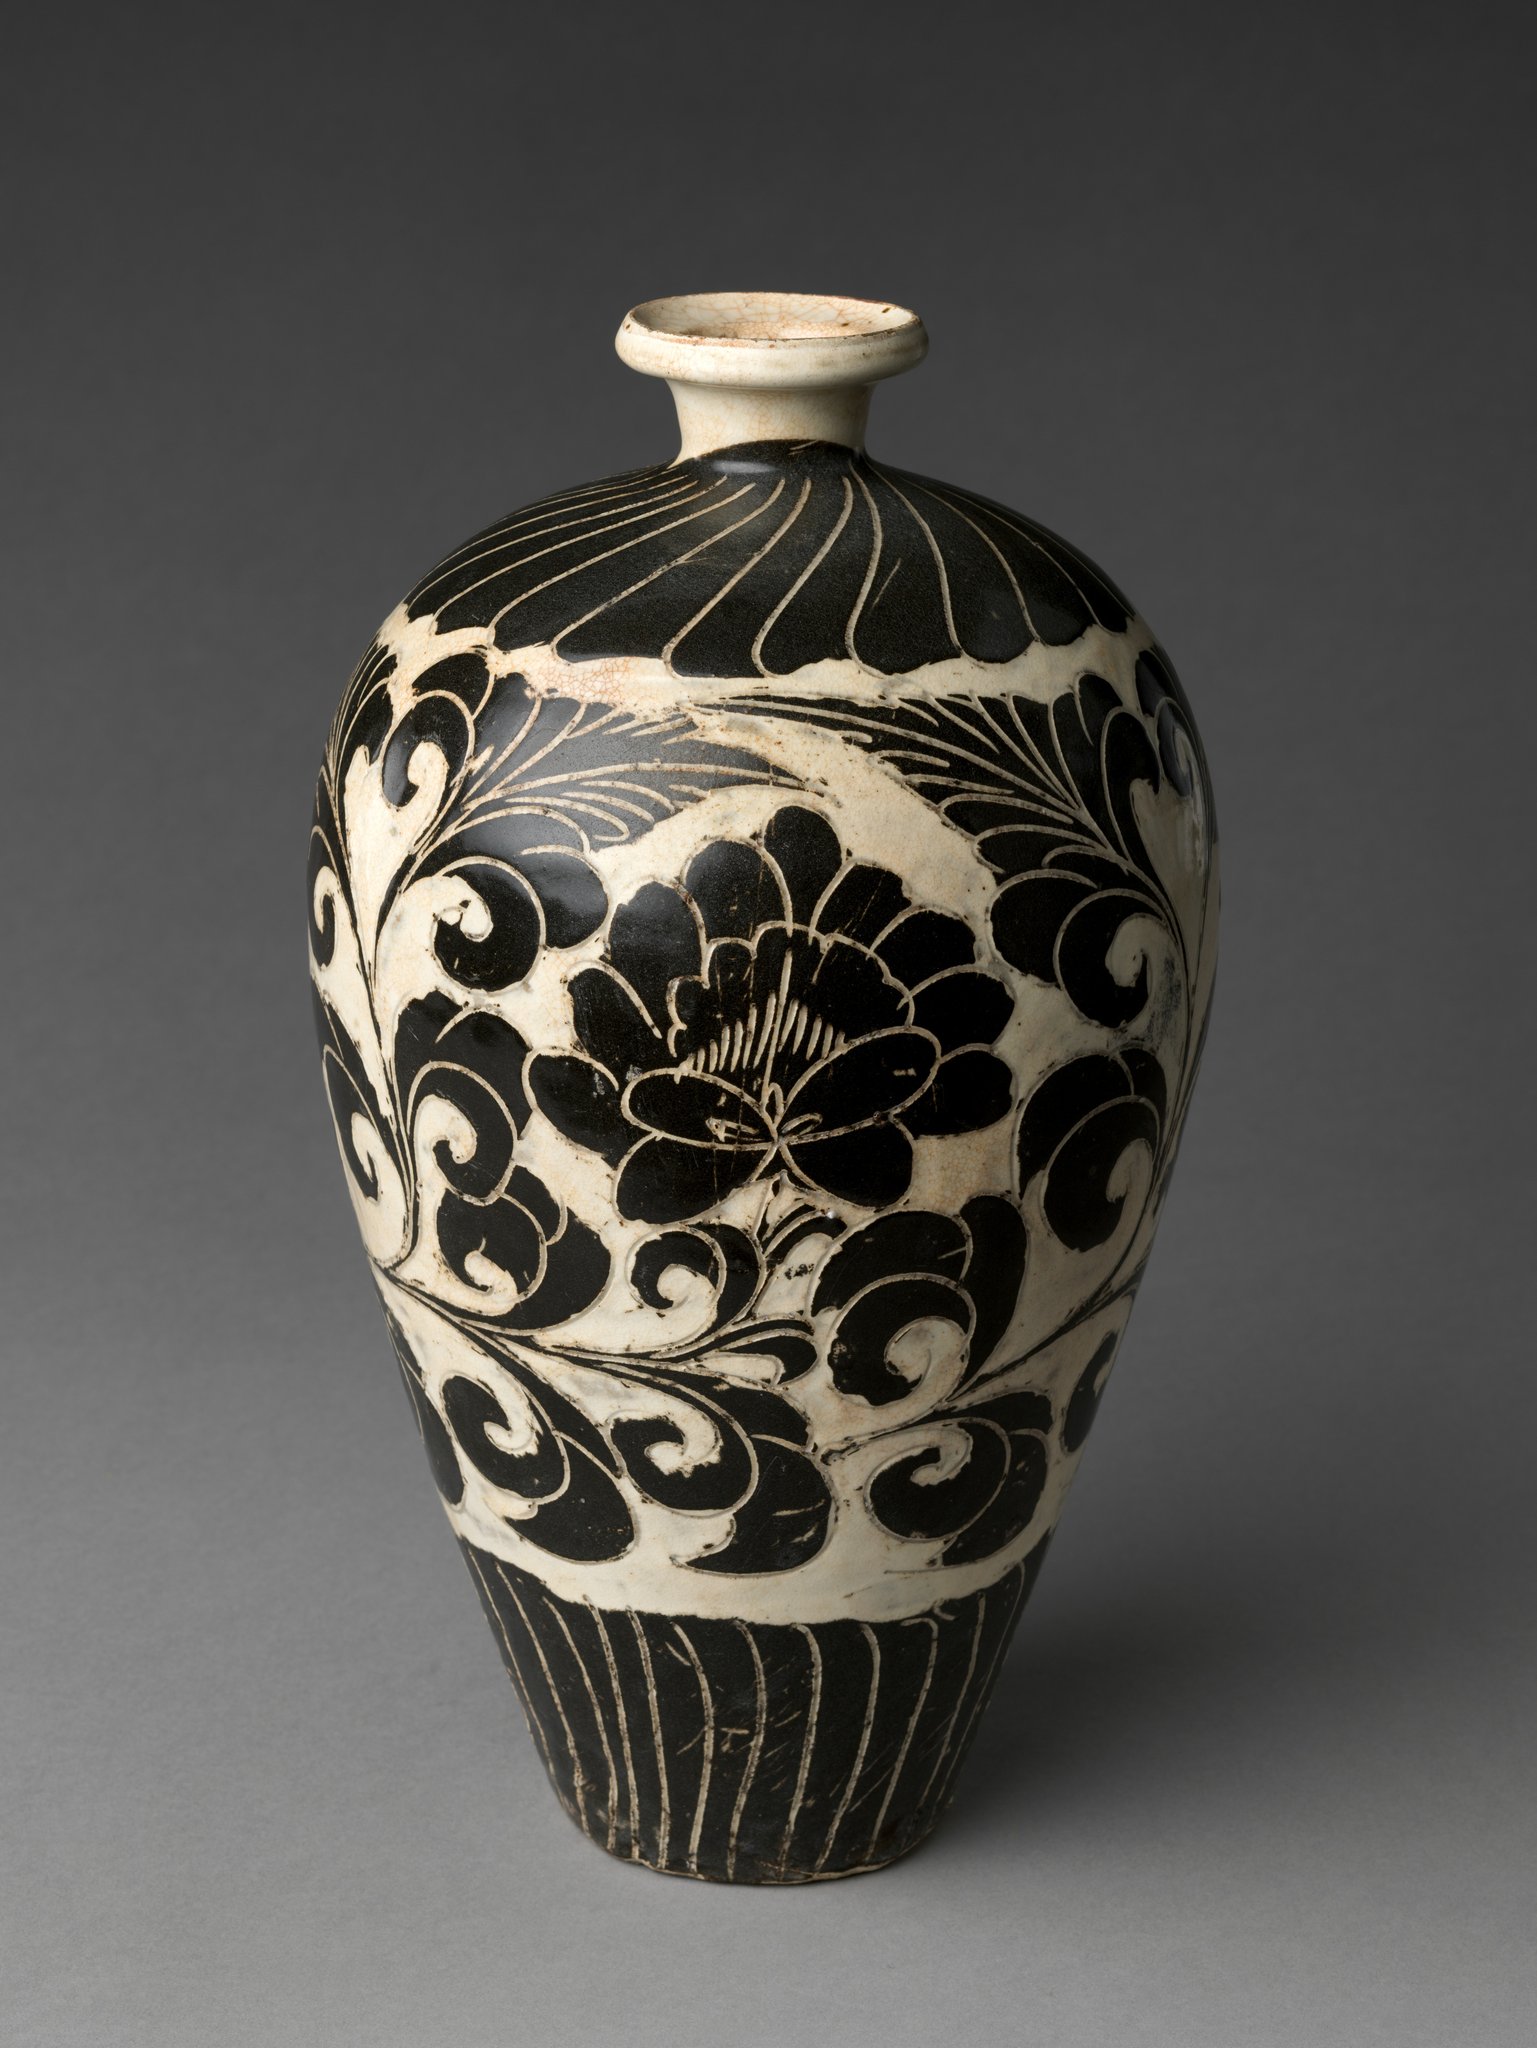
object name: vase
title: Vase with Peony Scroll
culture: chinese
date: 1001-1133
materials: glaze, stoneware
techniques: cutting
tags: peonies,leaves